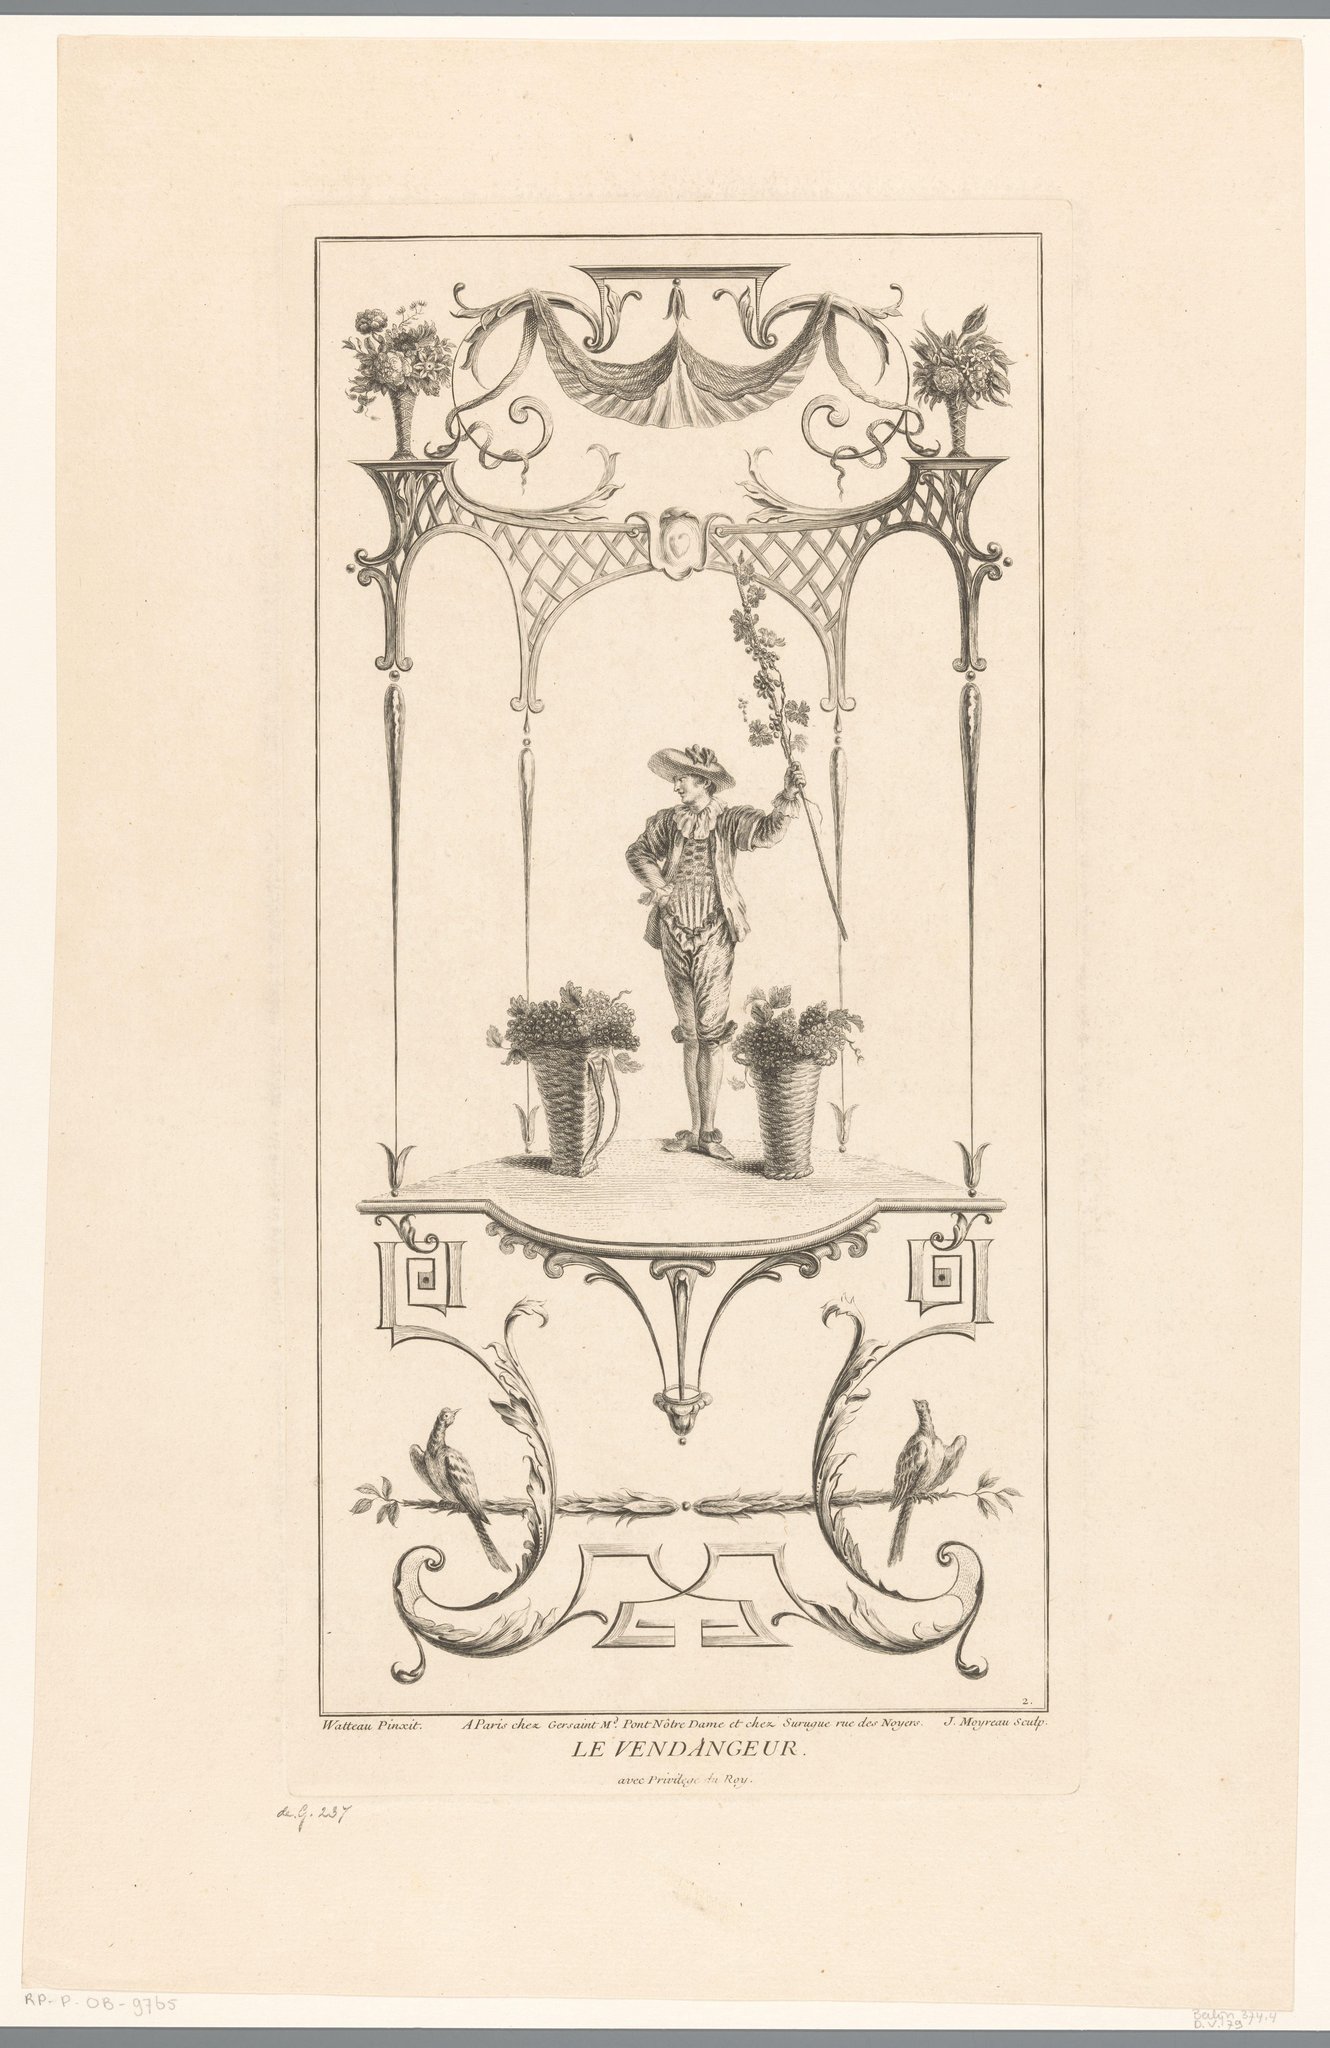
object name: print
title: Le Vendangeur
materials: paper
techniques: etching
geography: paris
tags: picking fruit, vintage, grape harvest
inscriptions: collector's mark: Lugt 2228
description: Een druivenplukker staat met een wijnstok en twee manden gevuld met druiven onder ornamentele bogen met vazen. Rondom de voorstelling een ornamentele omlijsting met arabesken en vogels.